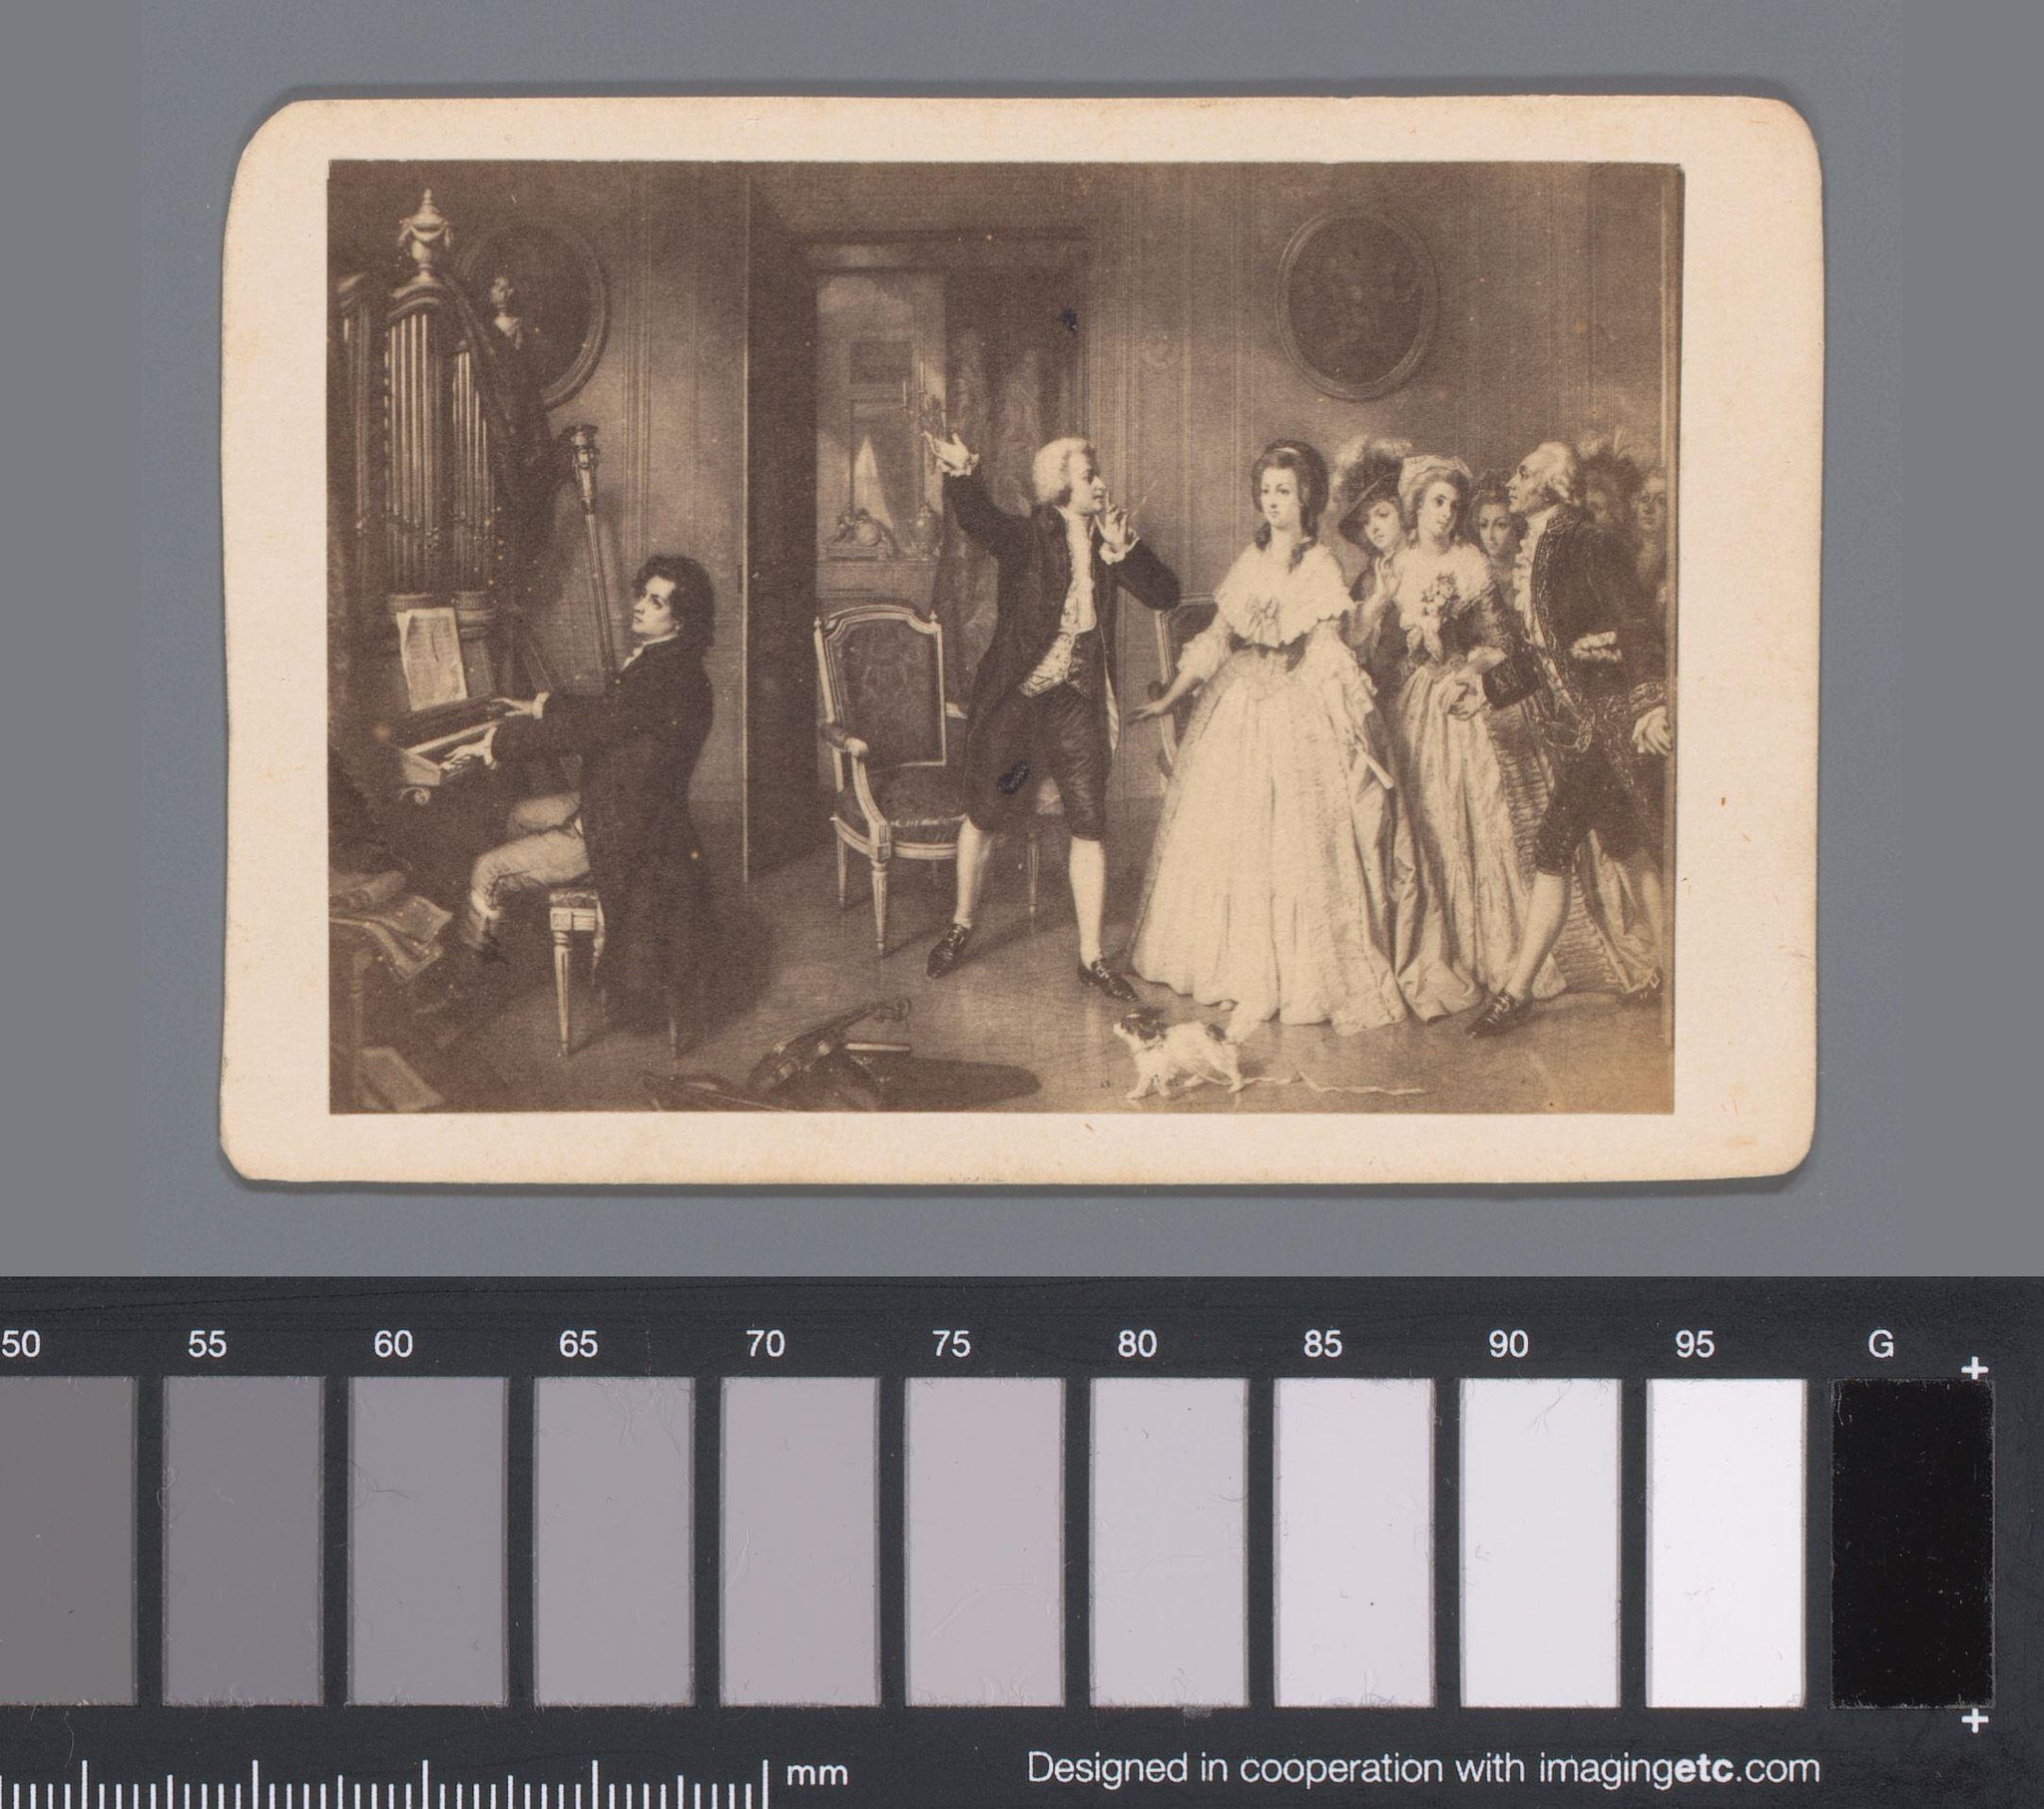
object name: photograph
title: Fotoreproductie van een prent van Paul Allais naar het schilderij getiteld Beethoven chez Mozart door H. Merle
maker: Anonymous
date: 1855-1885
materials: cardboard, paper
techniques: albumen print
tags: one person playing an instrument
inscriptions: number: ‘1333.’, title: ‘Beethoven chez Mozart’